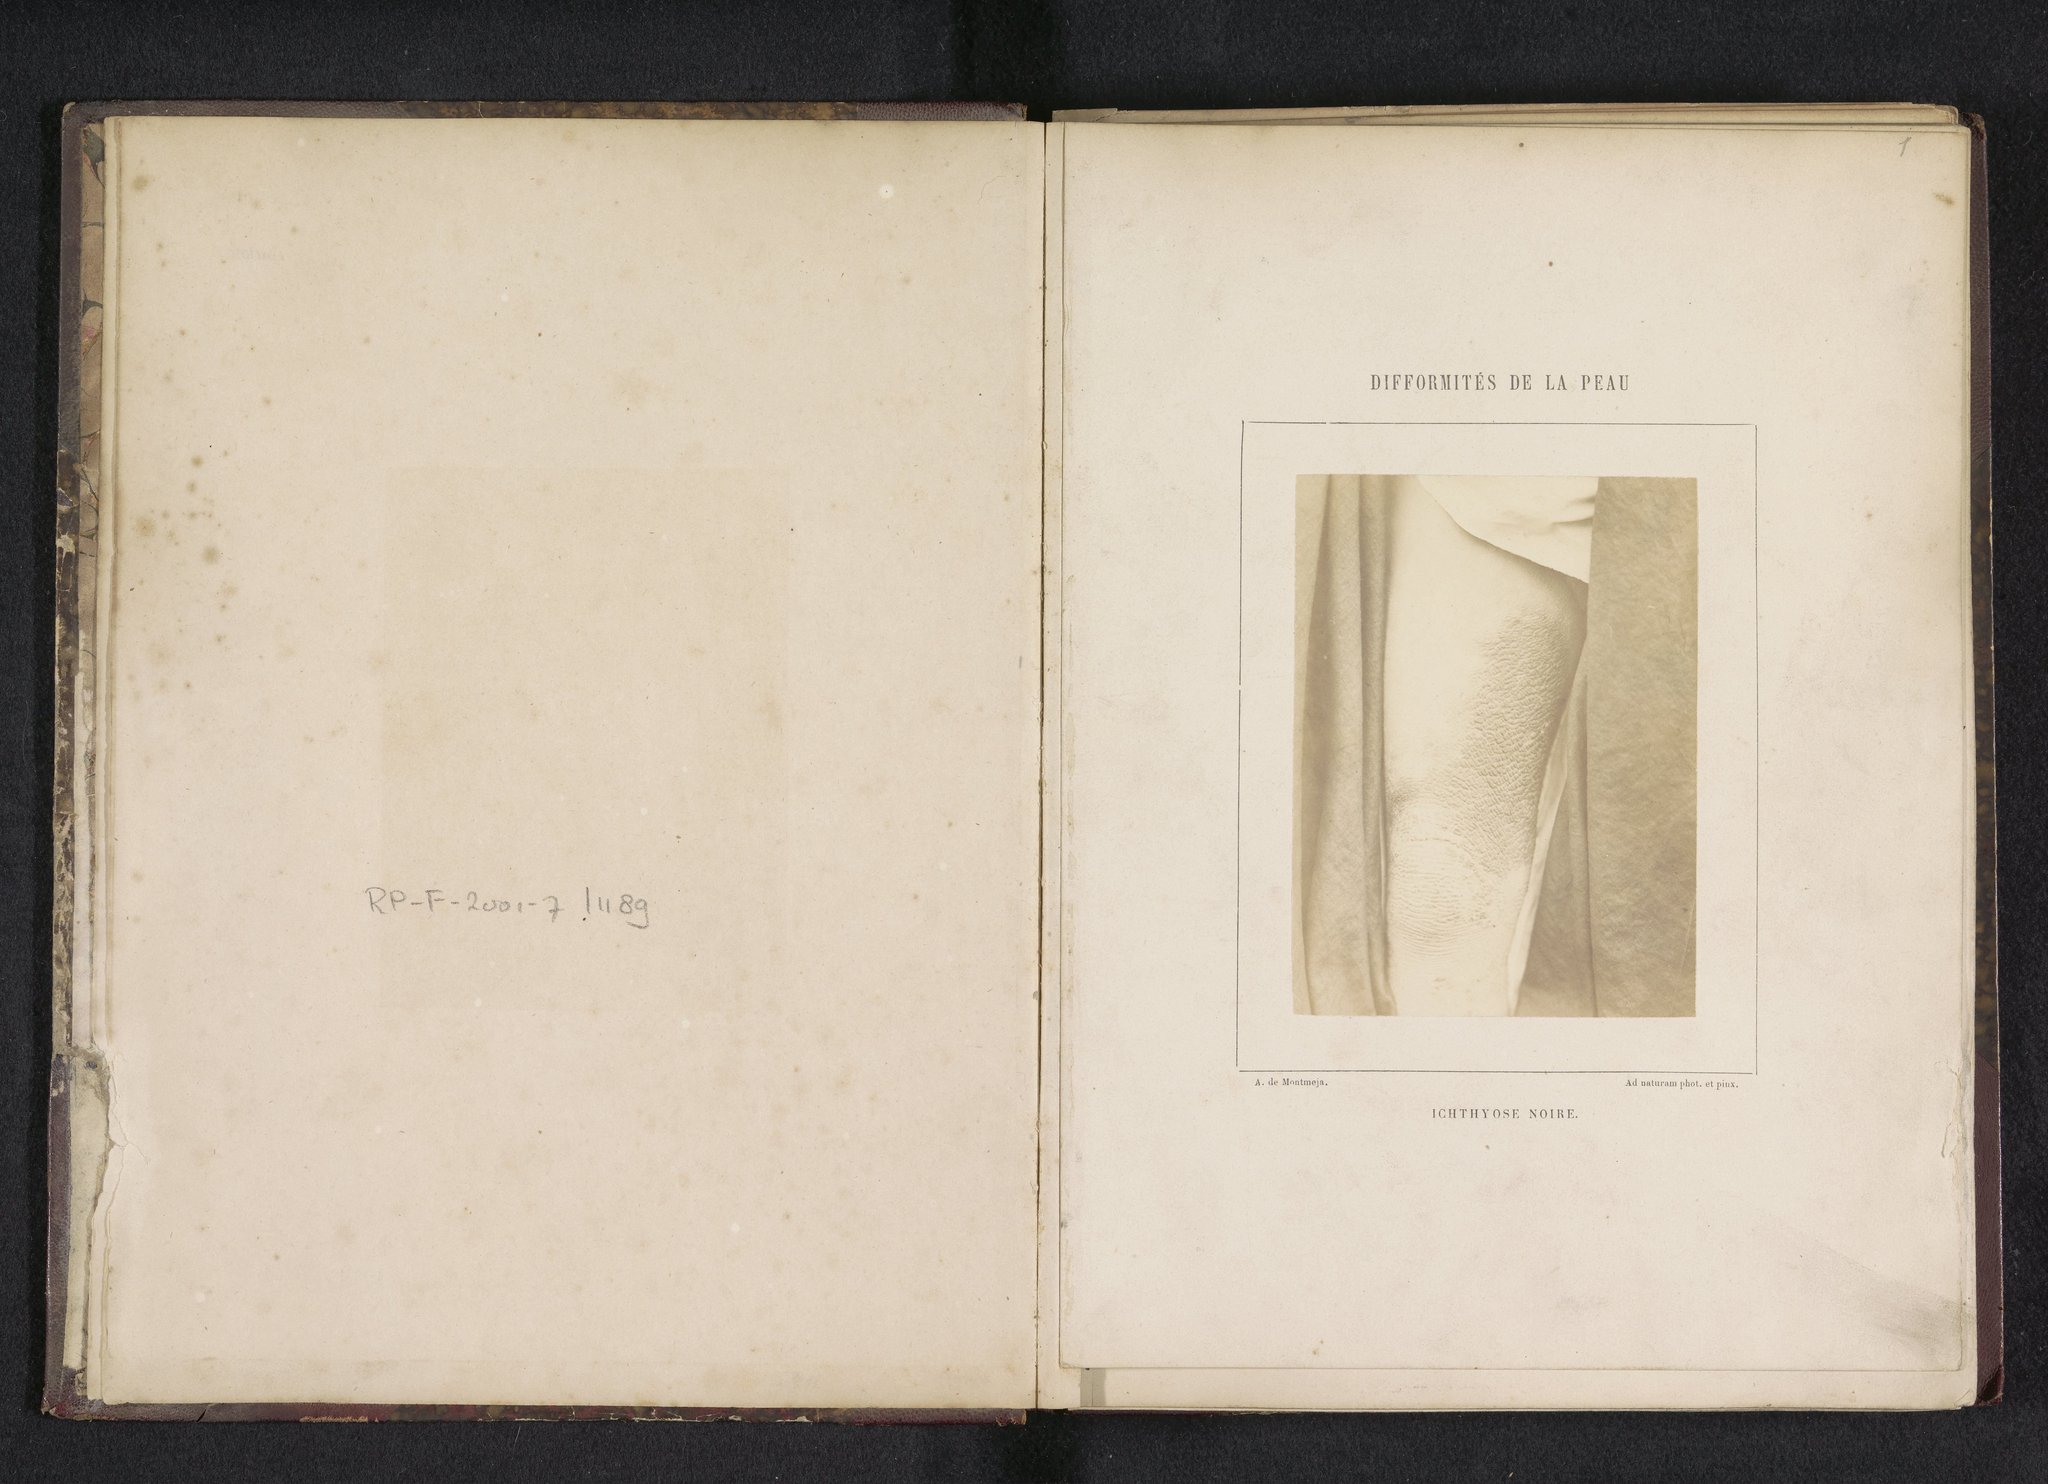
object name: page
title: Ichthyose noire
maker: a. de montméja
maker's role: arts, fotograaf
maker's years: 1841-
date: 1868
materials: photographic support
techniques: albumen print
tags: skin and venereal diseases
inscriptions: number: ‘1’, inscription: ‘Difformités de la Peau’, inscription: ‘Ad naturam phot. et pinx.’